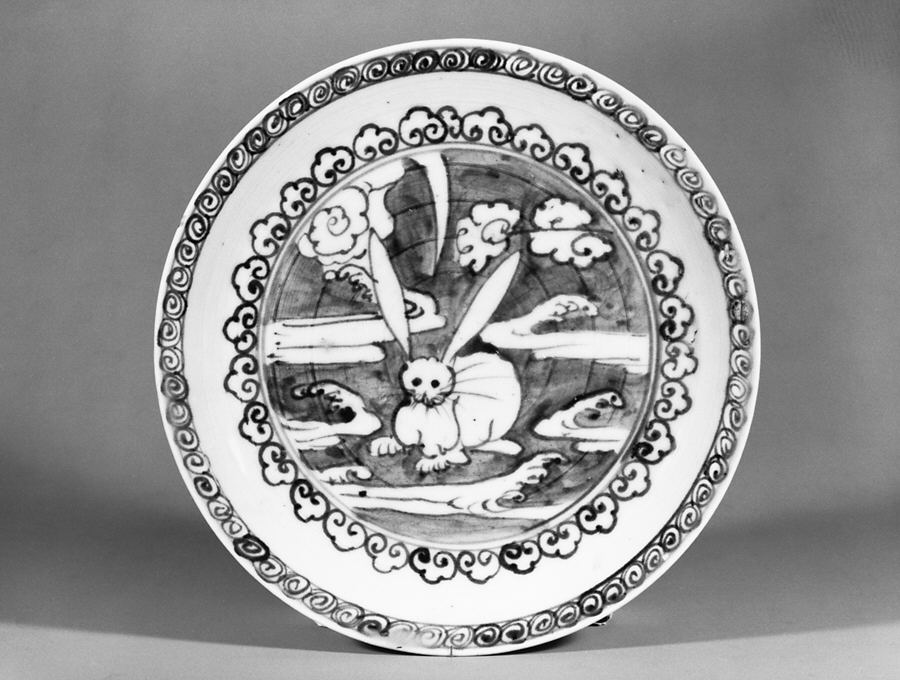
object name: dish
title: Dish with Design of Hare in Clouds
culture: japanese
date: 1624-1643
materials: cobalt, porcelain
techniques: underglaze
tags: rabbits